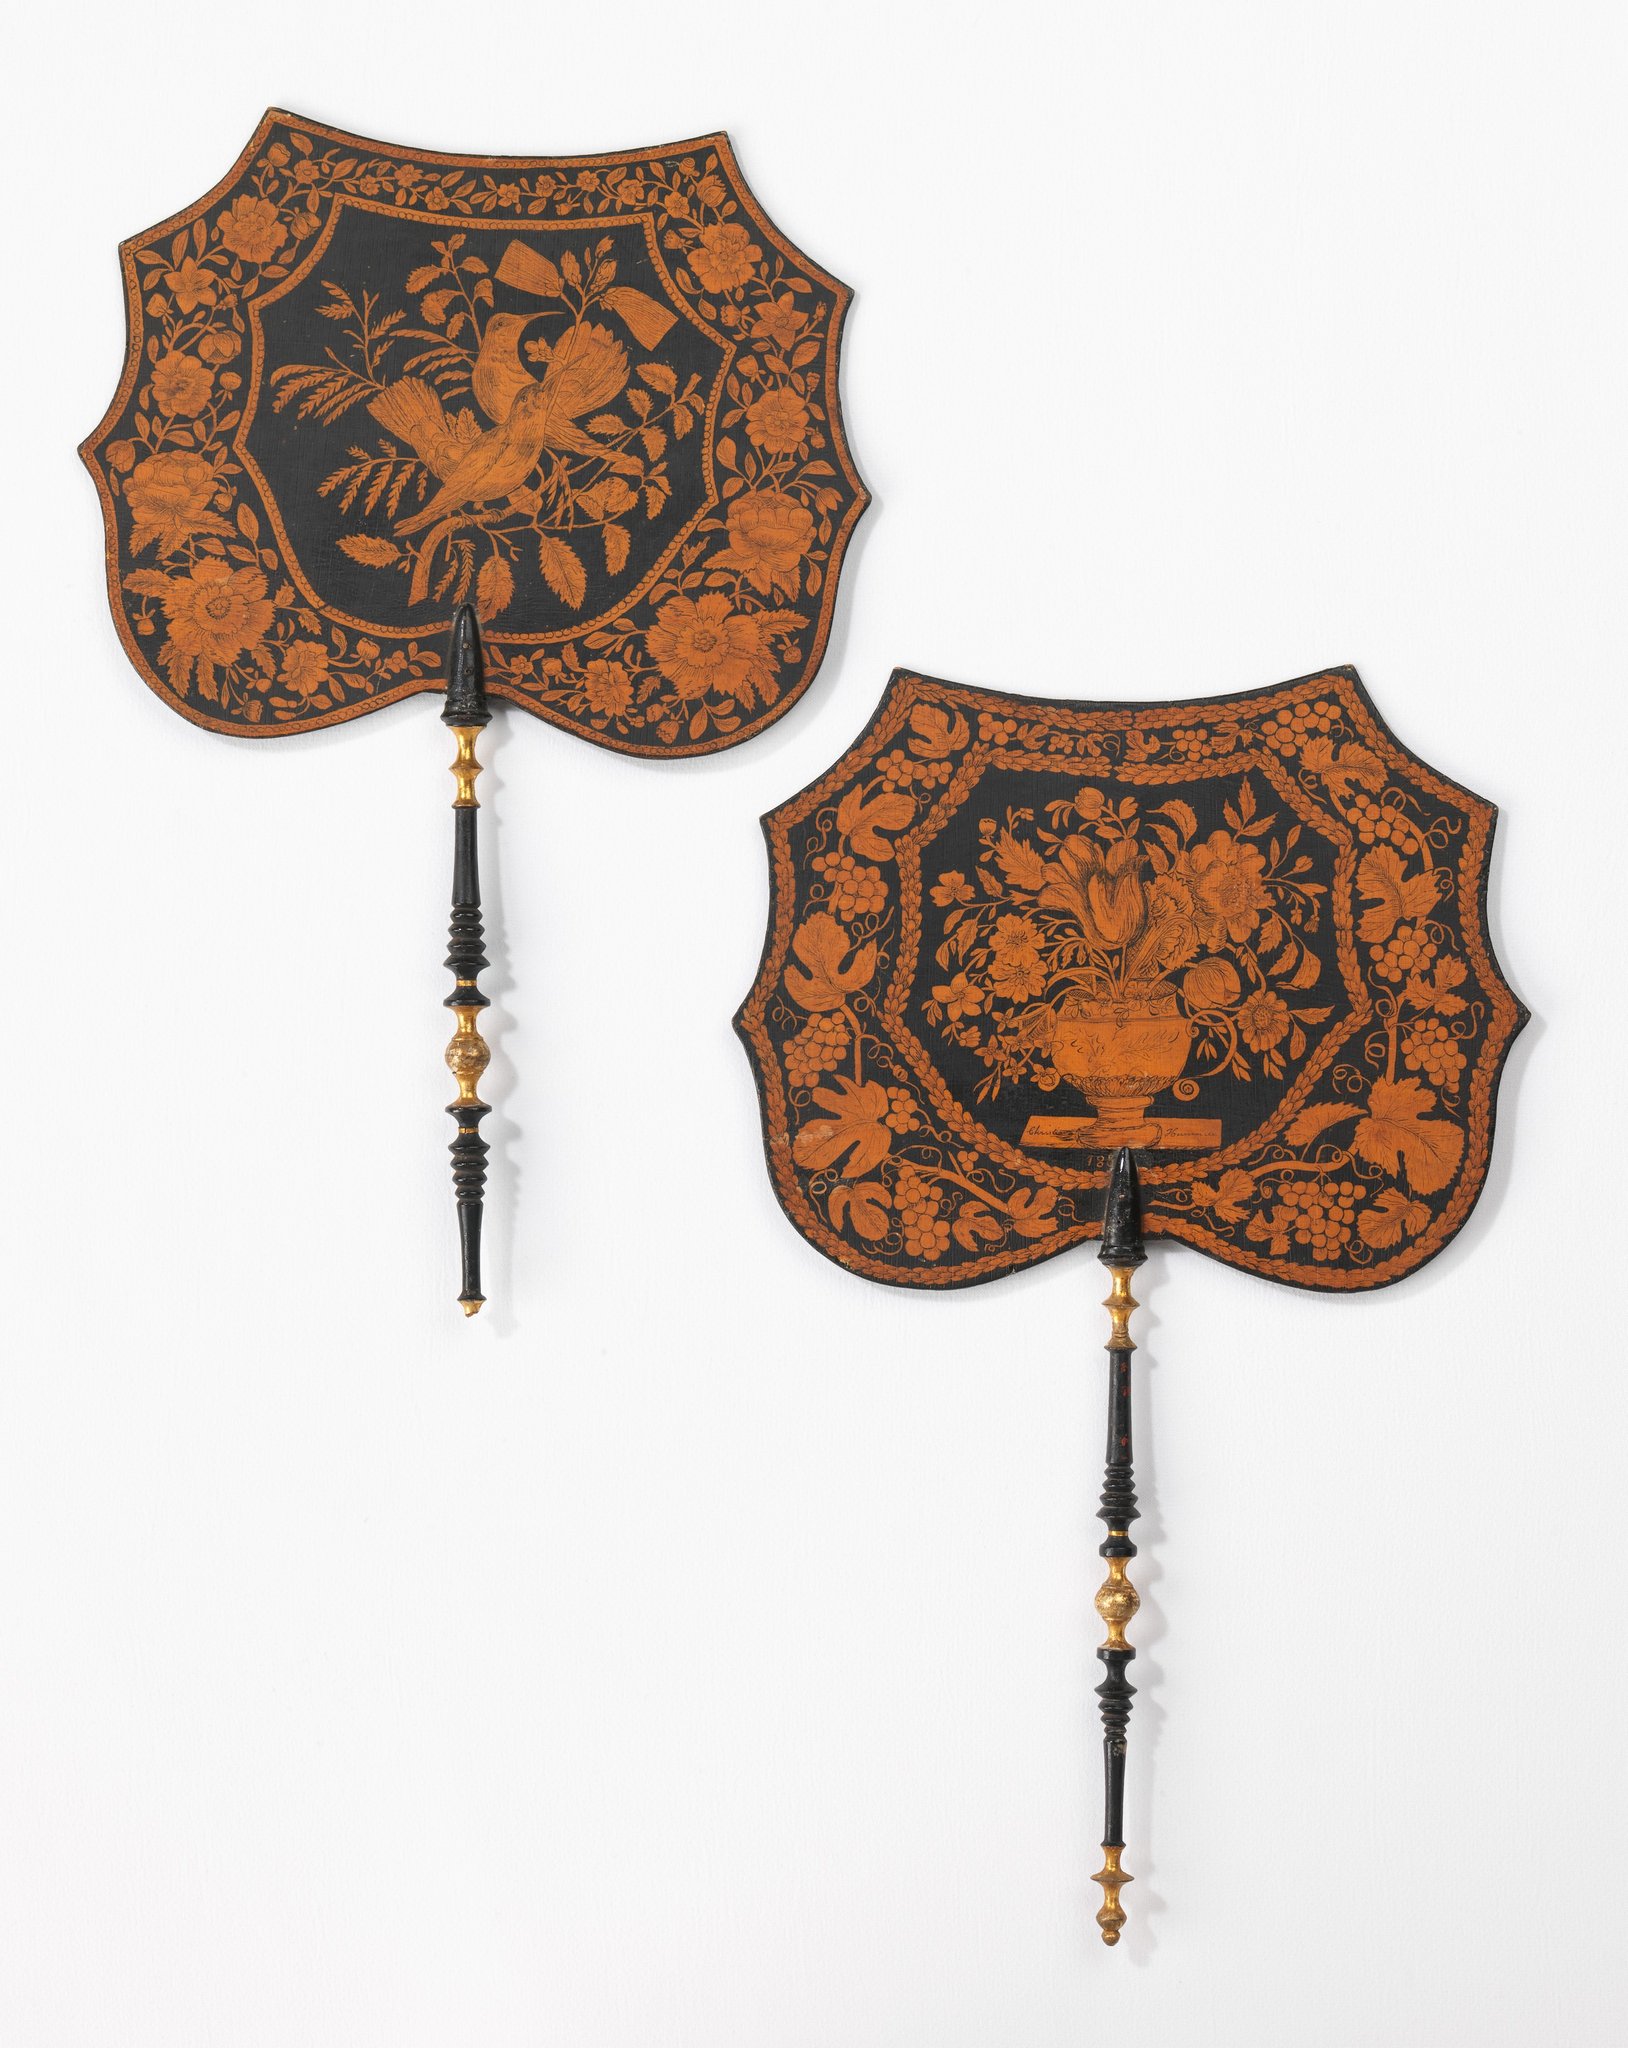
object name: fan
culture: american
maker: christiana hummer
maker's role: artist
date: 1837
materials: paint, wood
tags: birds,grapes,flowers,vases